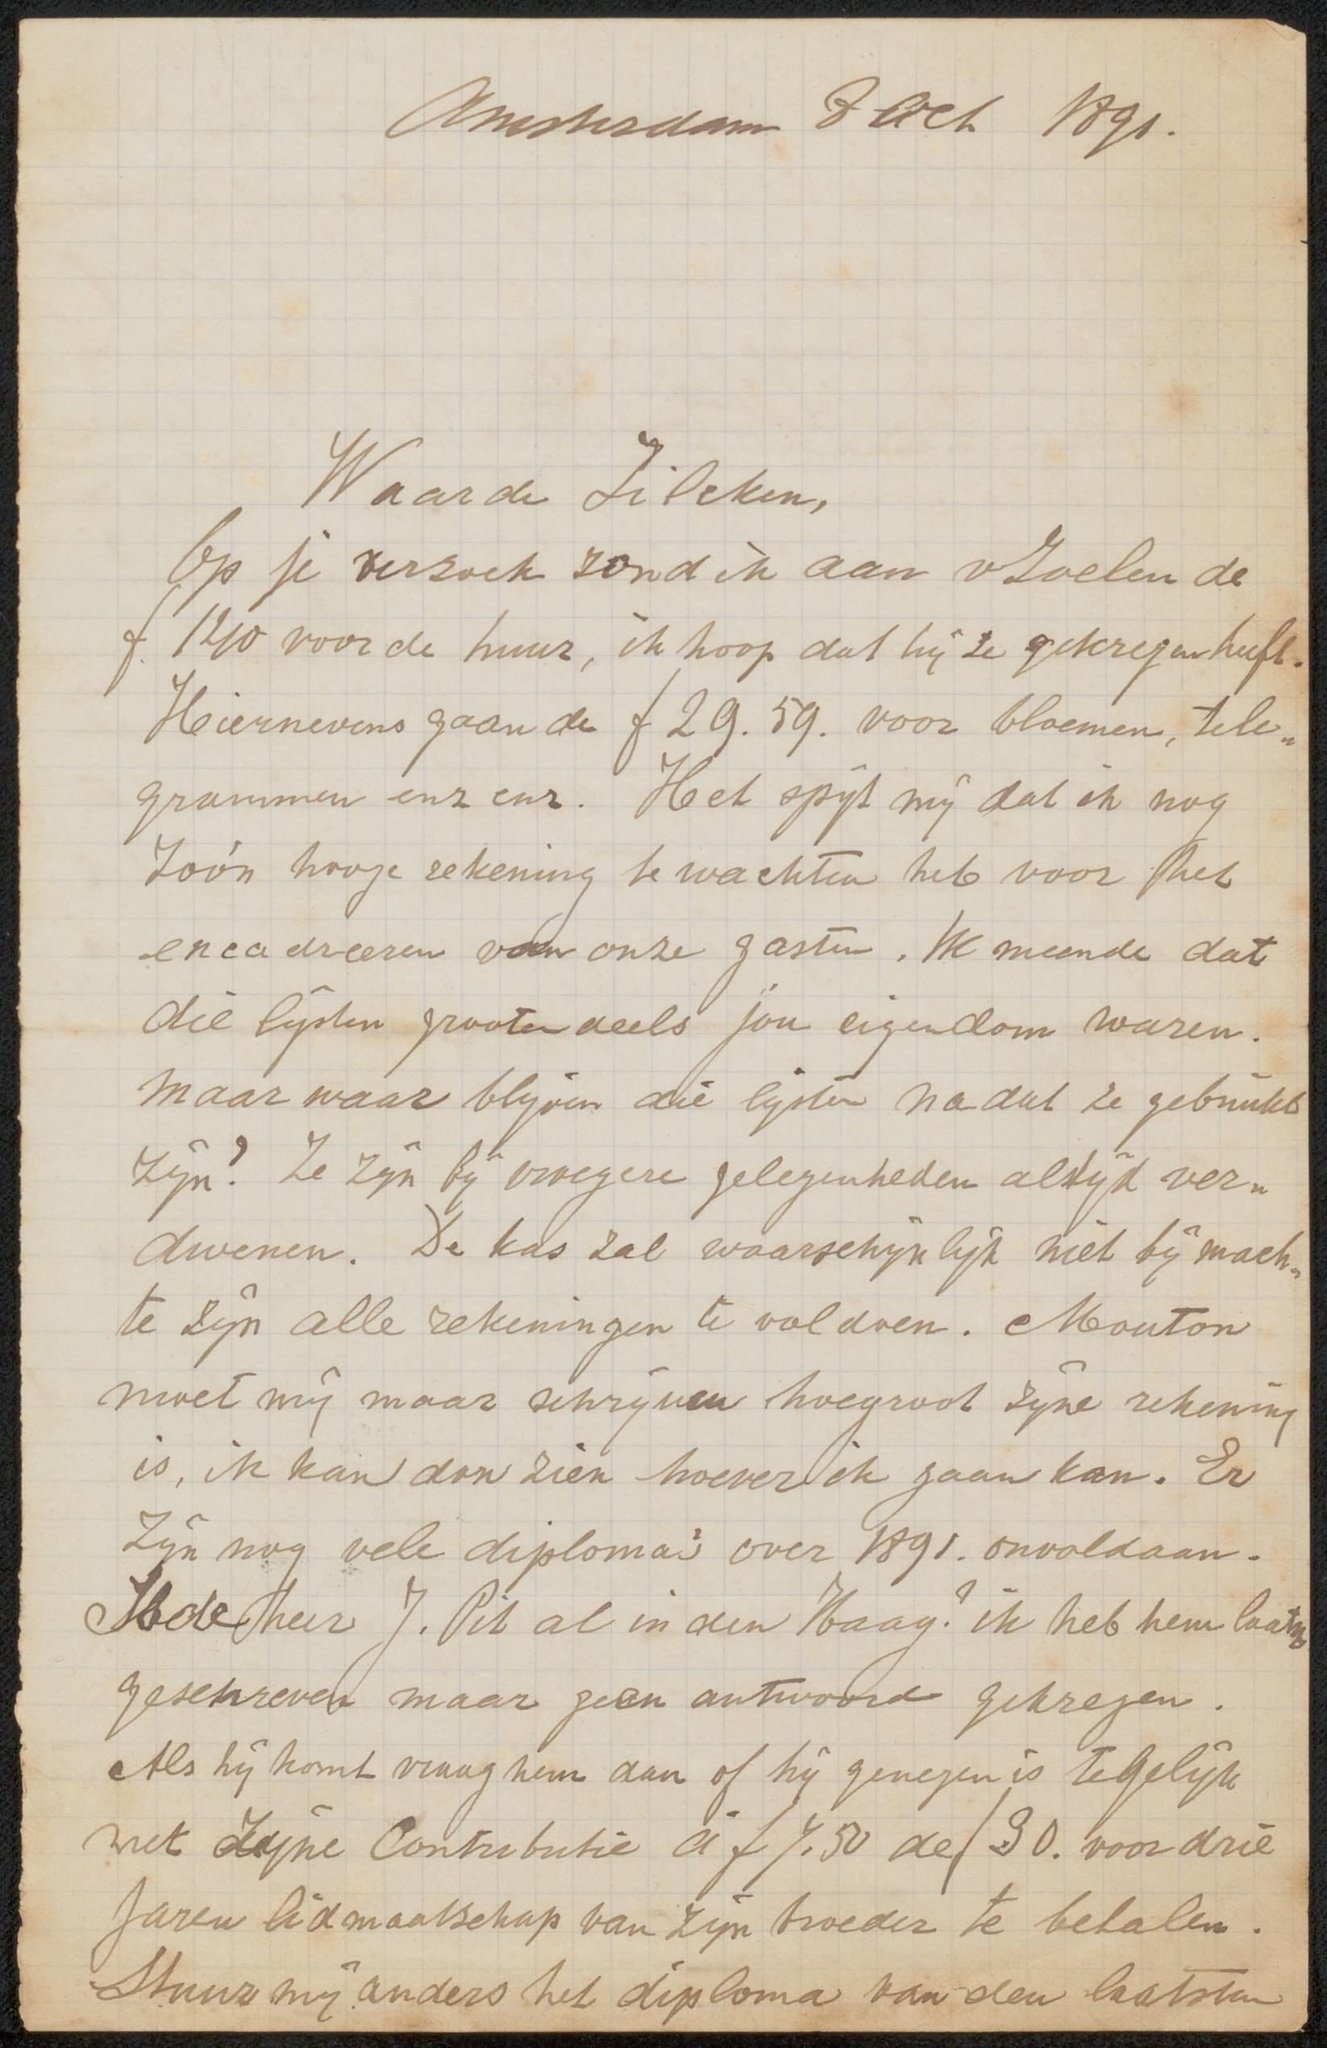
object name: letter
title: Brief aan Philip Zilcken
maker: eduard karsen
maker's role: draughtsman, painter, print maker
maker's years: 1860-1941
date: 1891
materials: ink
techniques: pen, writing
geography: amsterdam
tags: marinus van der maarel, amsterdam, print maker, marius bauer, adriaan pit, martinus mouton, the hague, painter, draughtsman, philip zilcken, money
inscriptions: collector's mark: ‘RPK’